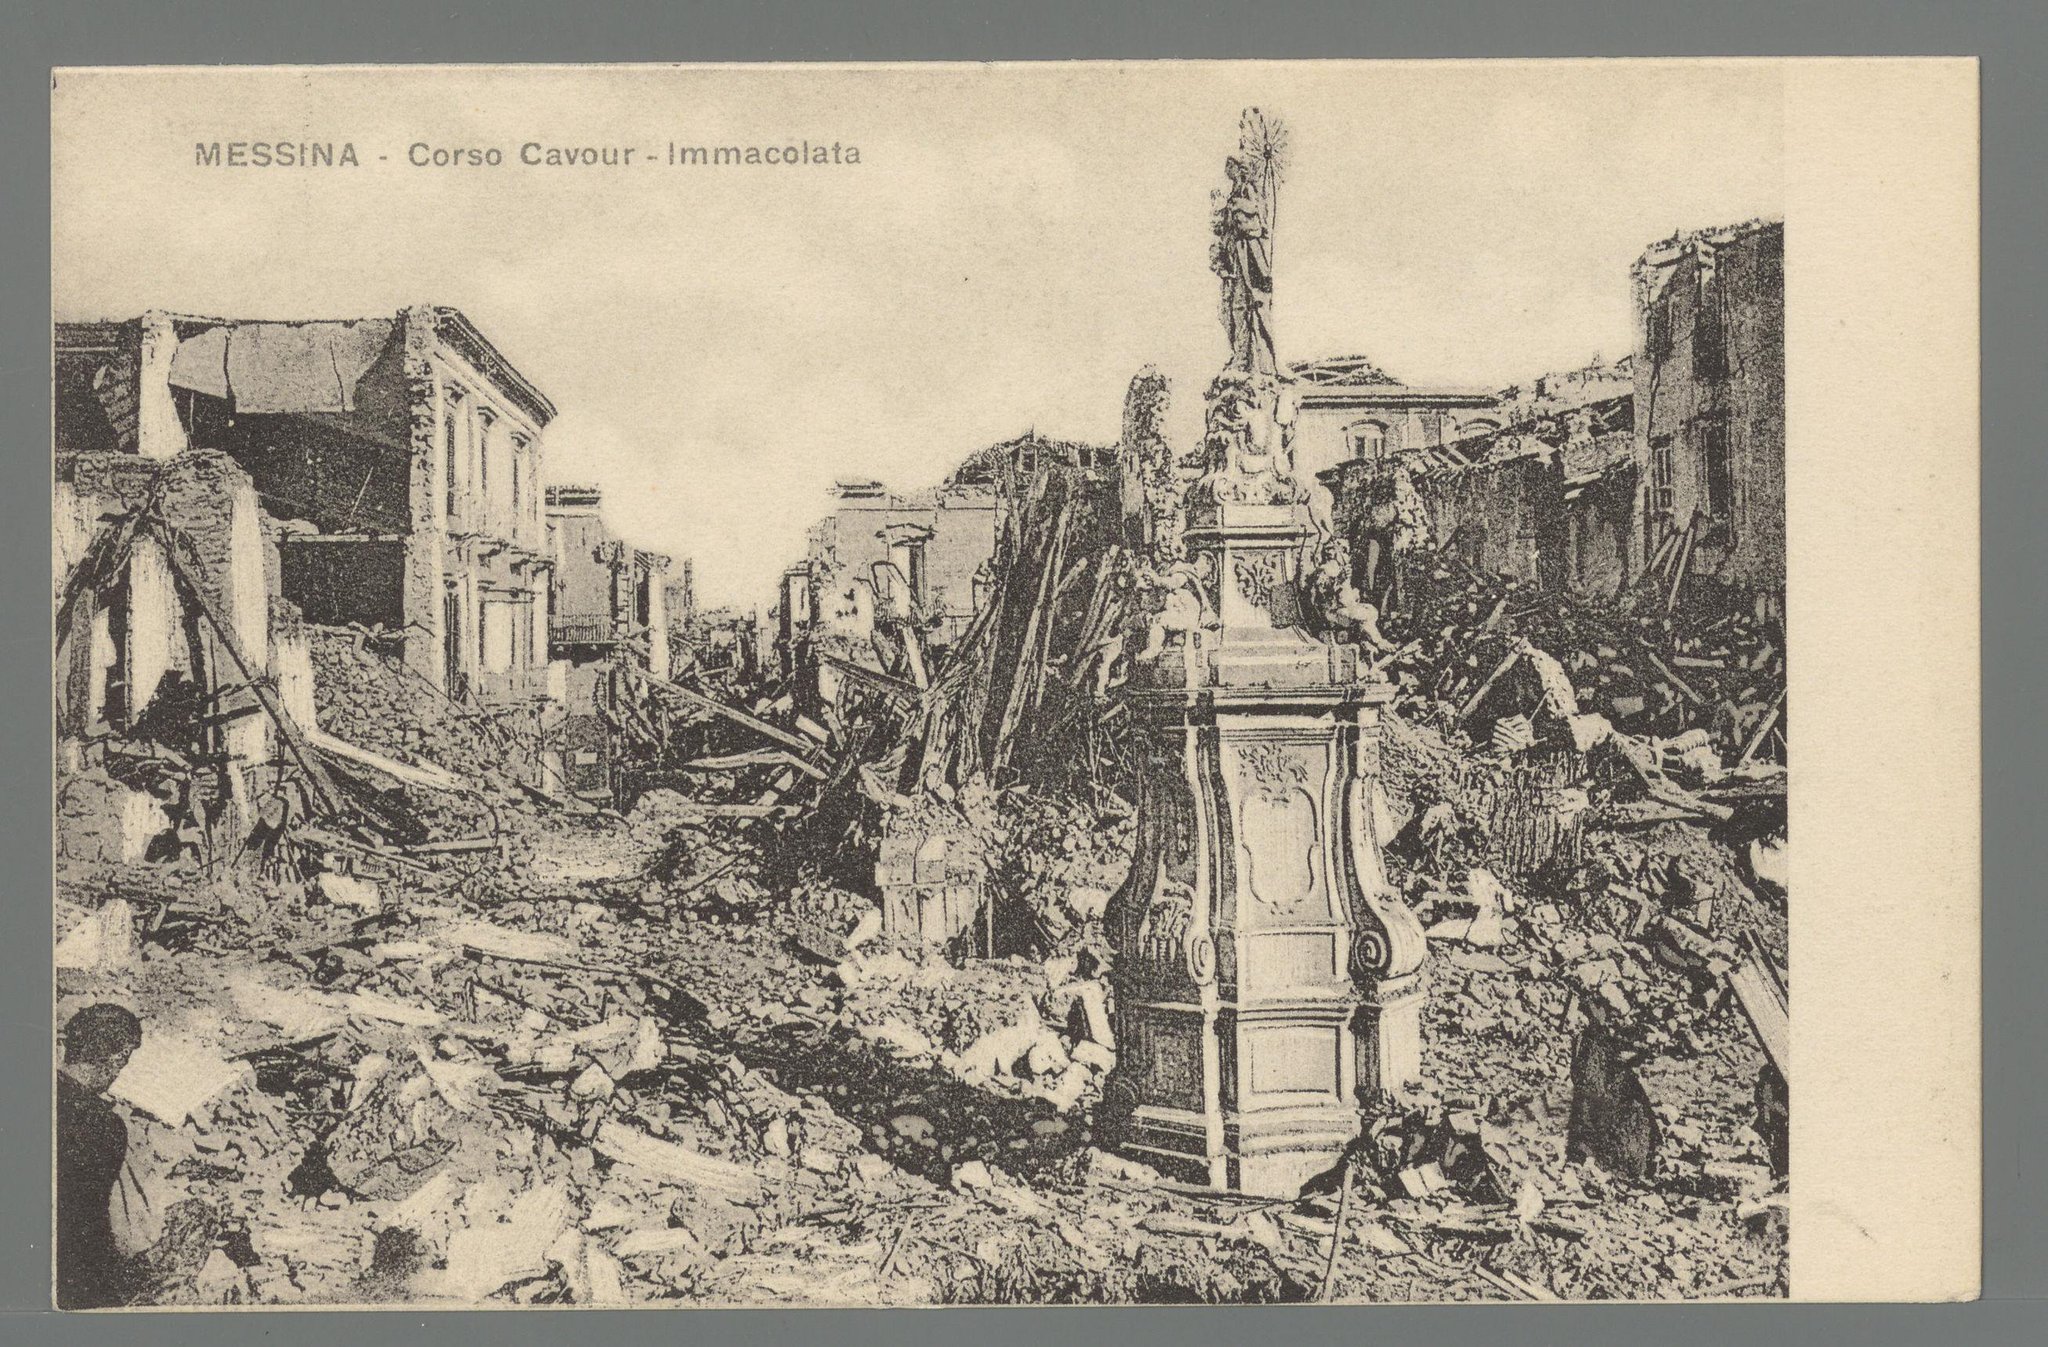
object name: ansichtkaart, prentbriefkaart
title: Messina. Corso Cavour. Immacolata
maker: Anonymous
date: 1908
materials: cardboard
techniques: photograph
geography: messina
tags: city-view, and landscape with man-made constructions, consequences of an earthquake, monument, statue